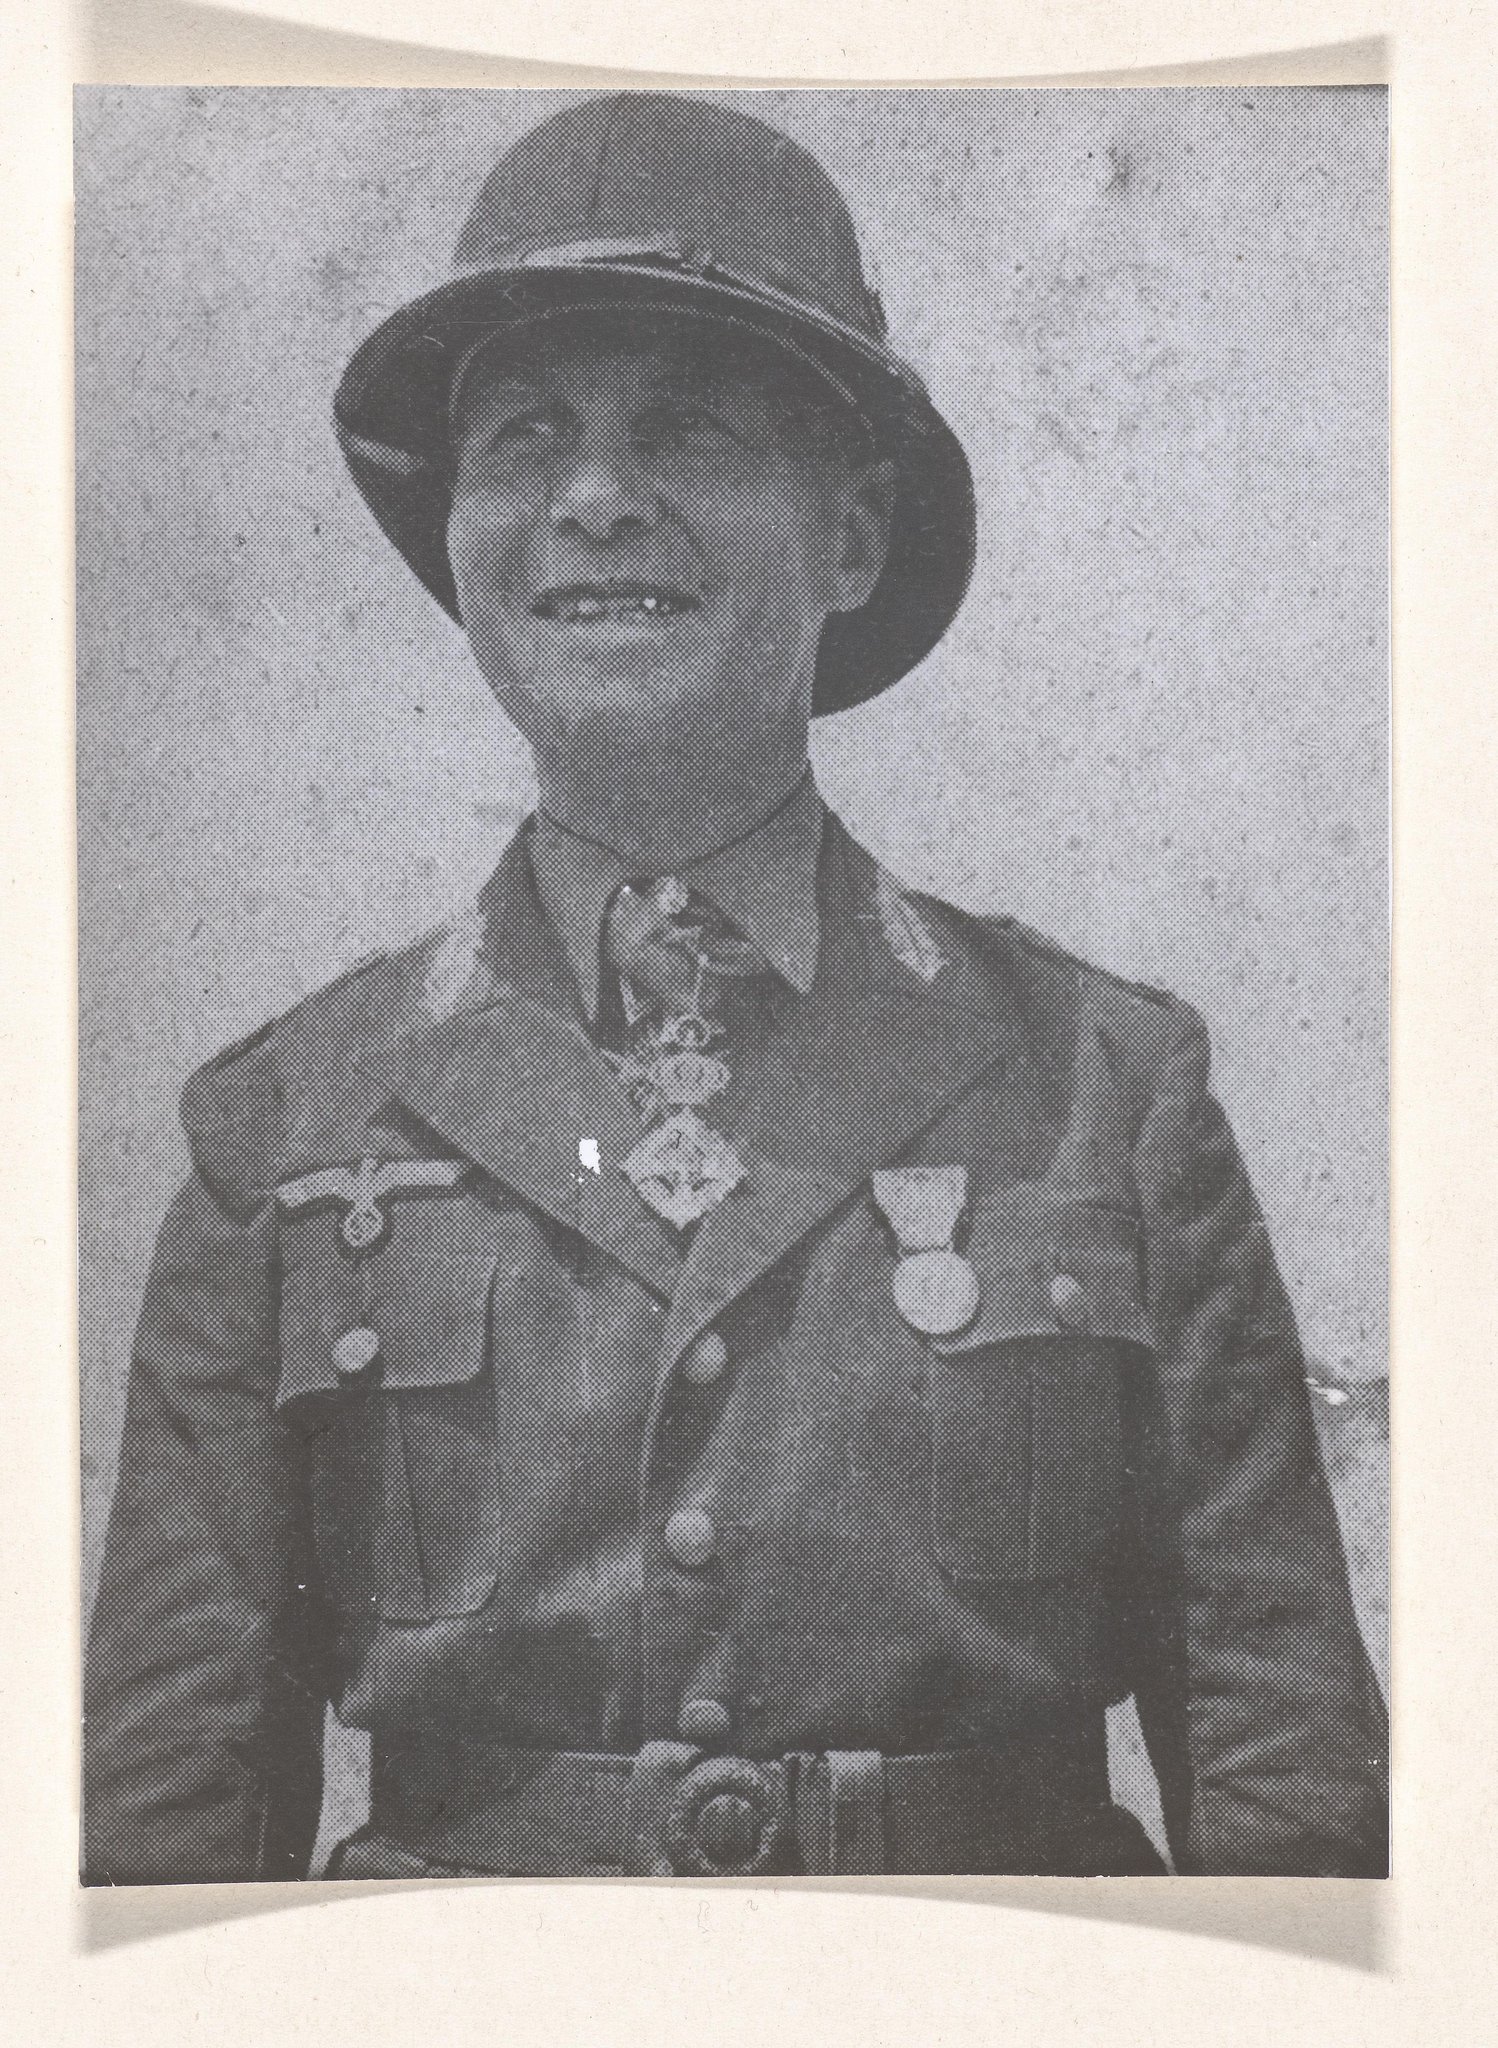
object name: photograph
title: Portret van Erwin Rommel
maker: Anonymous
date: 1939-1944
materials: photographic support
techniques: offset printed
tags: tweede wereldoorlog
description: Portret van de Duitse generaal-veldmaarschalk Erwin Rommel in uniform.